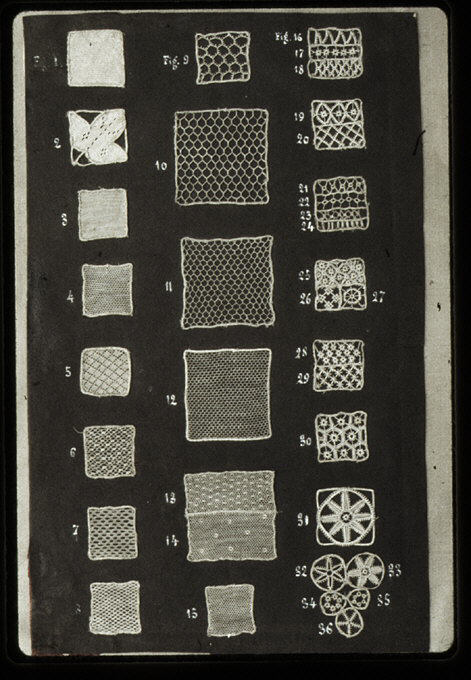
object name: sampler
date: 1801-1900